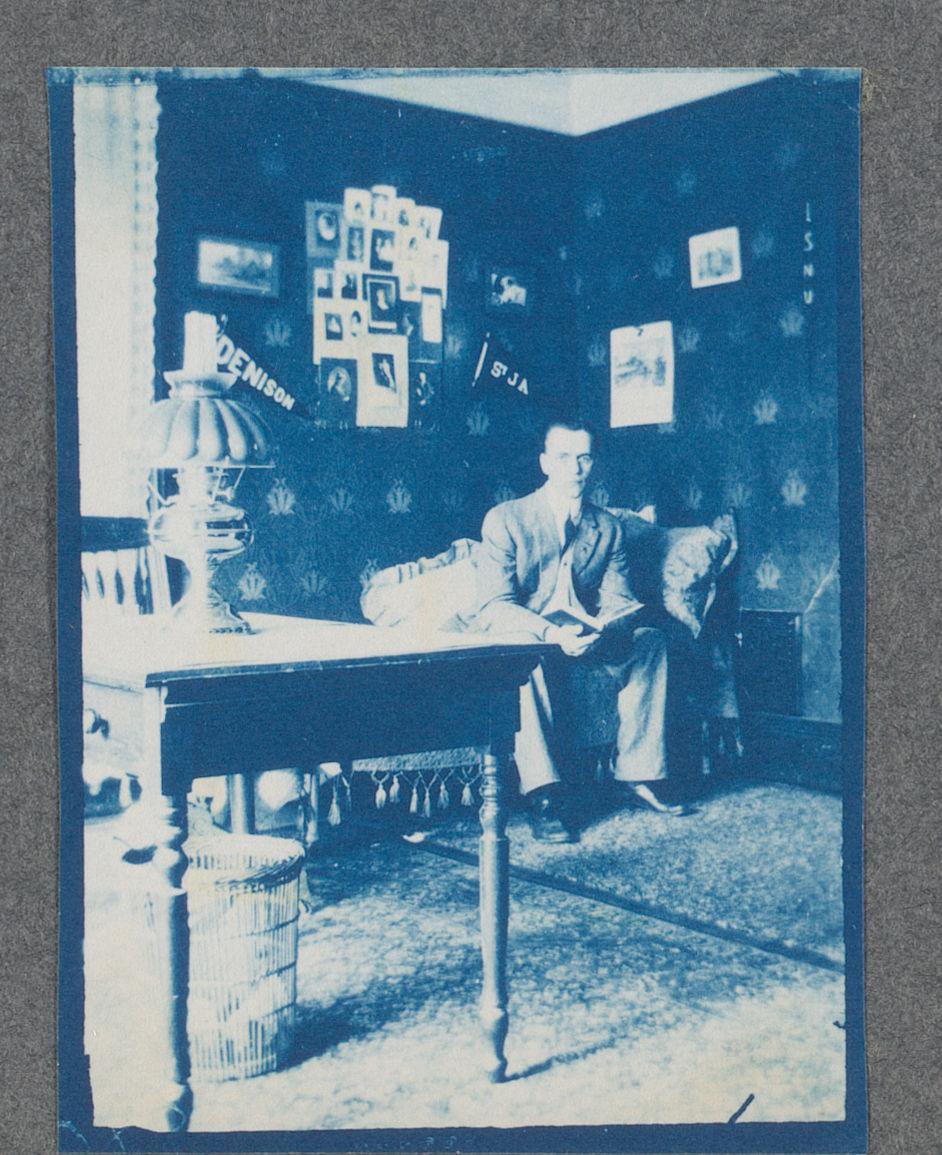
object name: album leaf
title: Student in zijn studentenkamer, mogelijk op de campus van Denison University in Ohio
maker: Anonymous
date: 1910-1920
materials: paper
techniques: cyanotype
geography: granville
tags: student